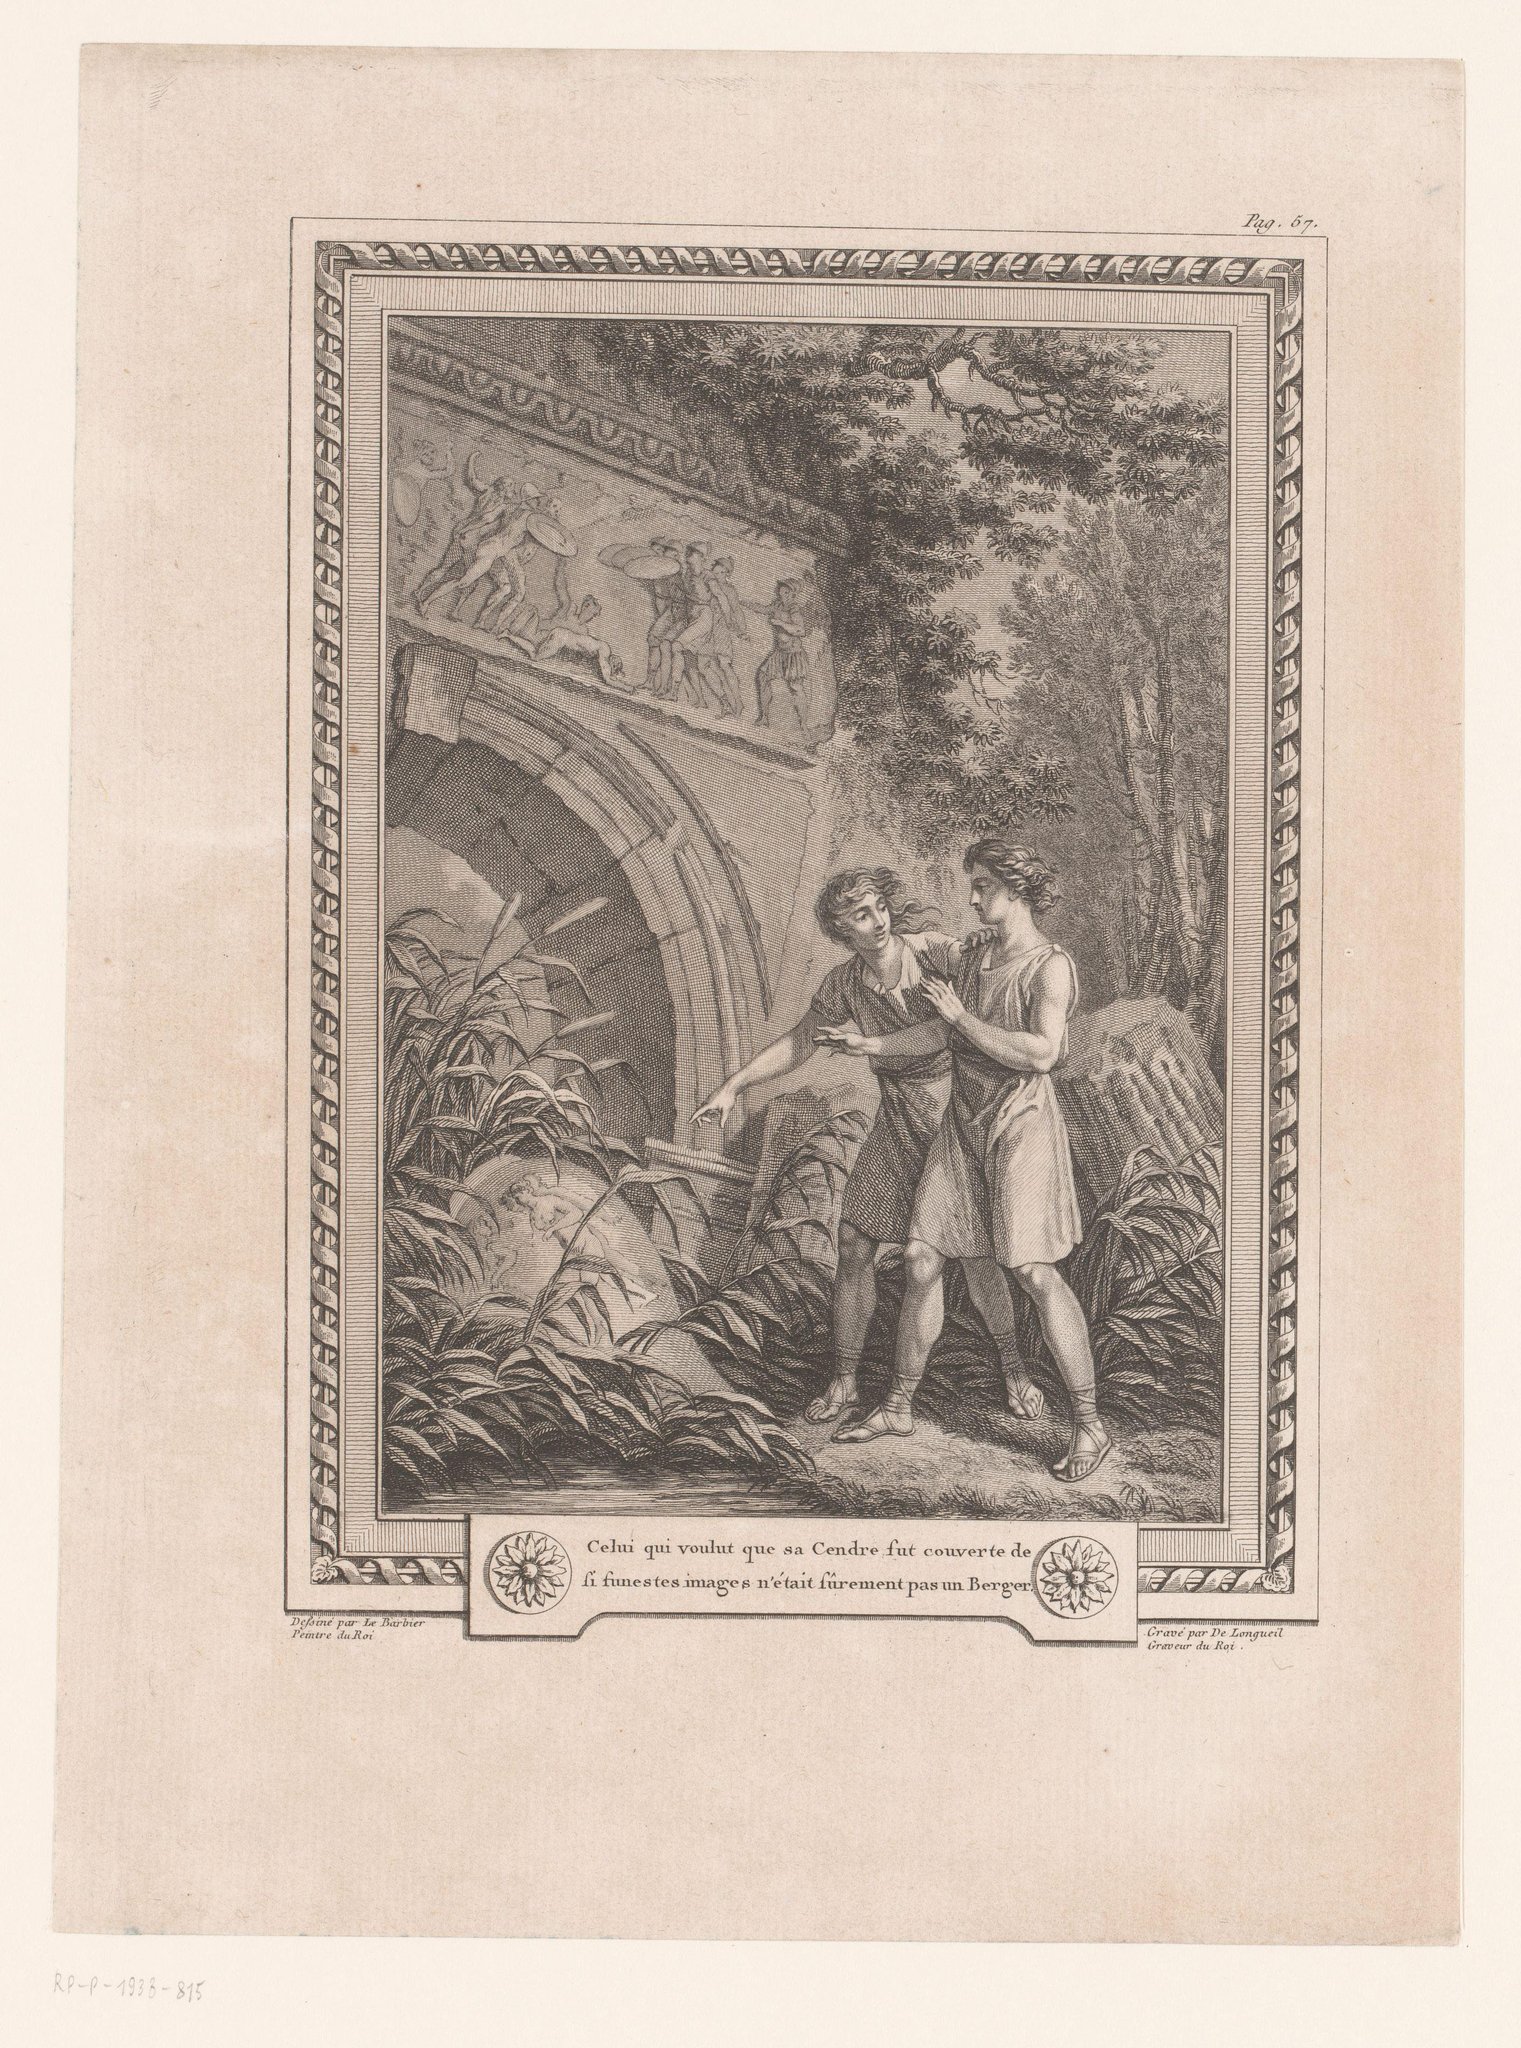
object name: print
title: Twee mannen voor een ruïne van een poort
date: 1740-1792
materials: paper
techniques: engraving, etching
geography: france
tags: landscape with ruins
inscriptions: collector's mark: Lugt 2228